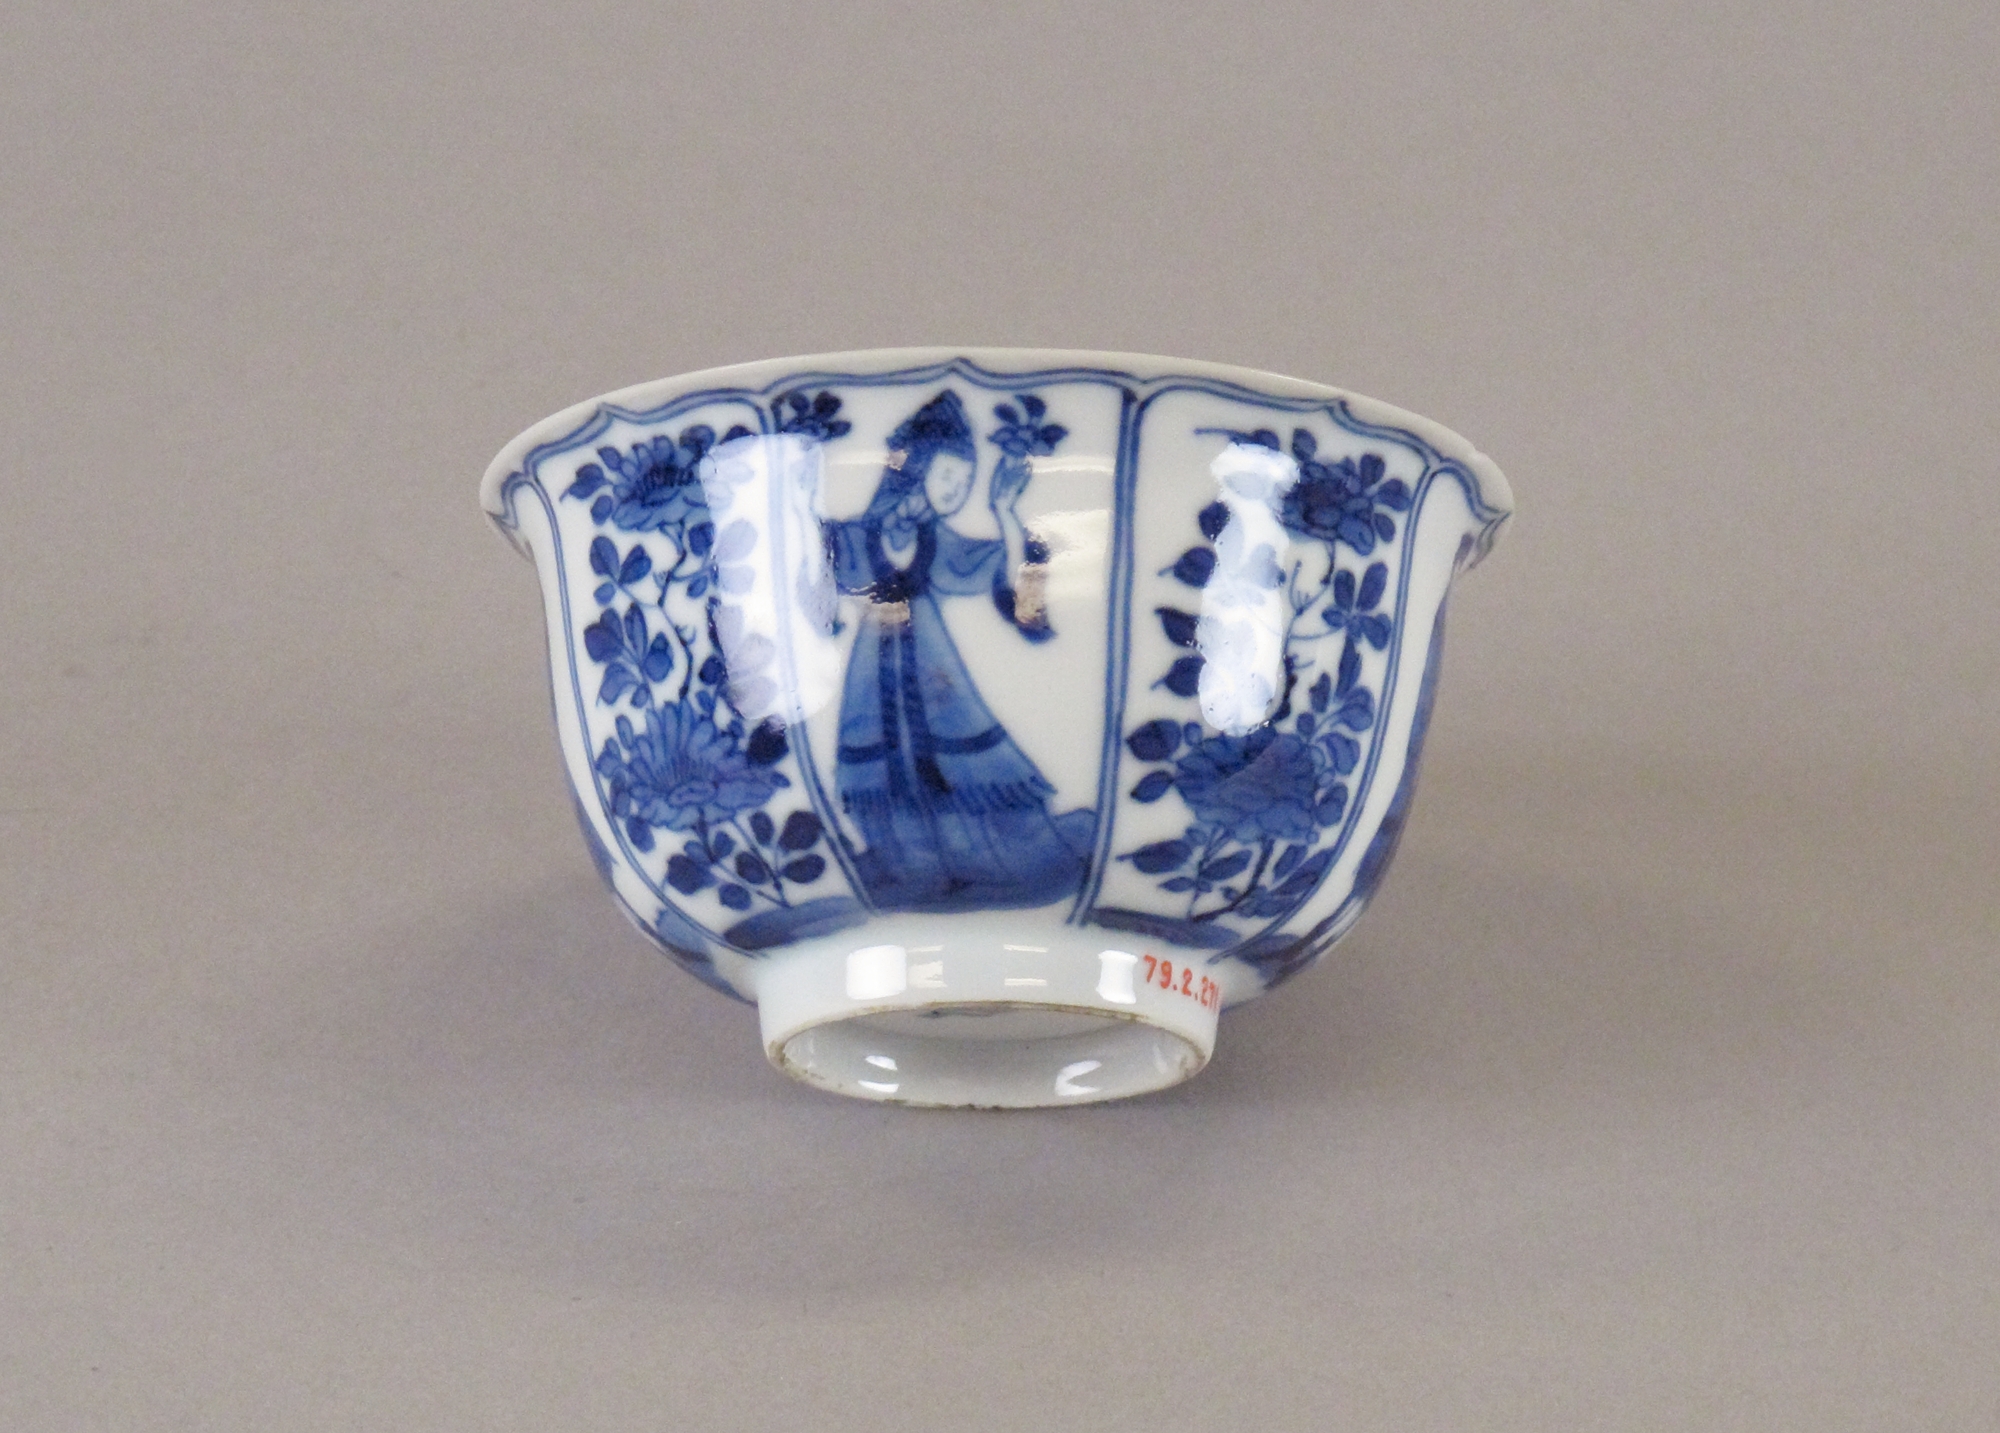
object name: cup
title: Cup with women and flowers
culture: chinese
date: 1644-1911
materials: porcelain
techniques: painting, underglaze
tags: women,flowers